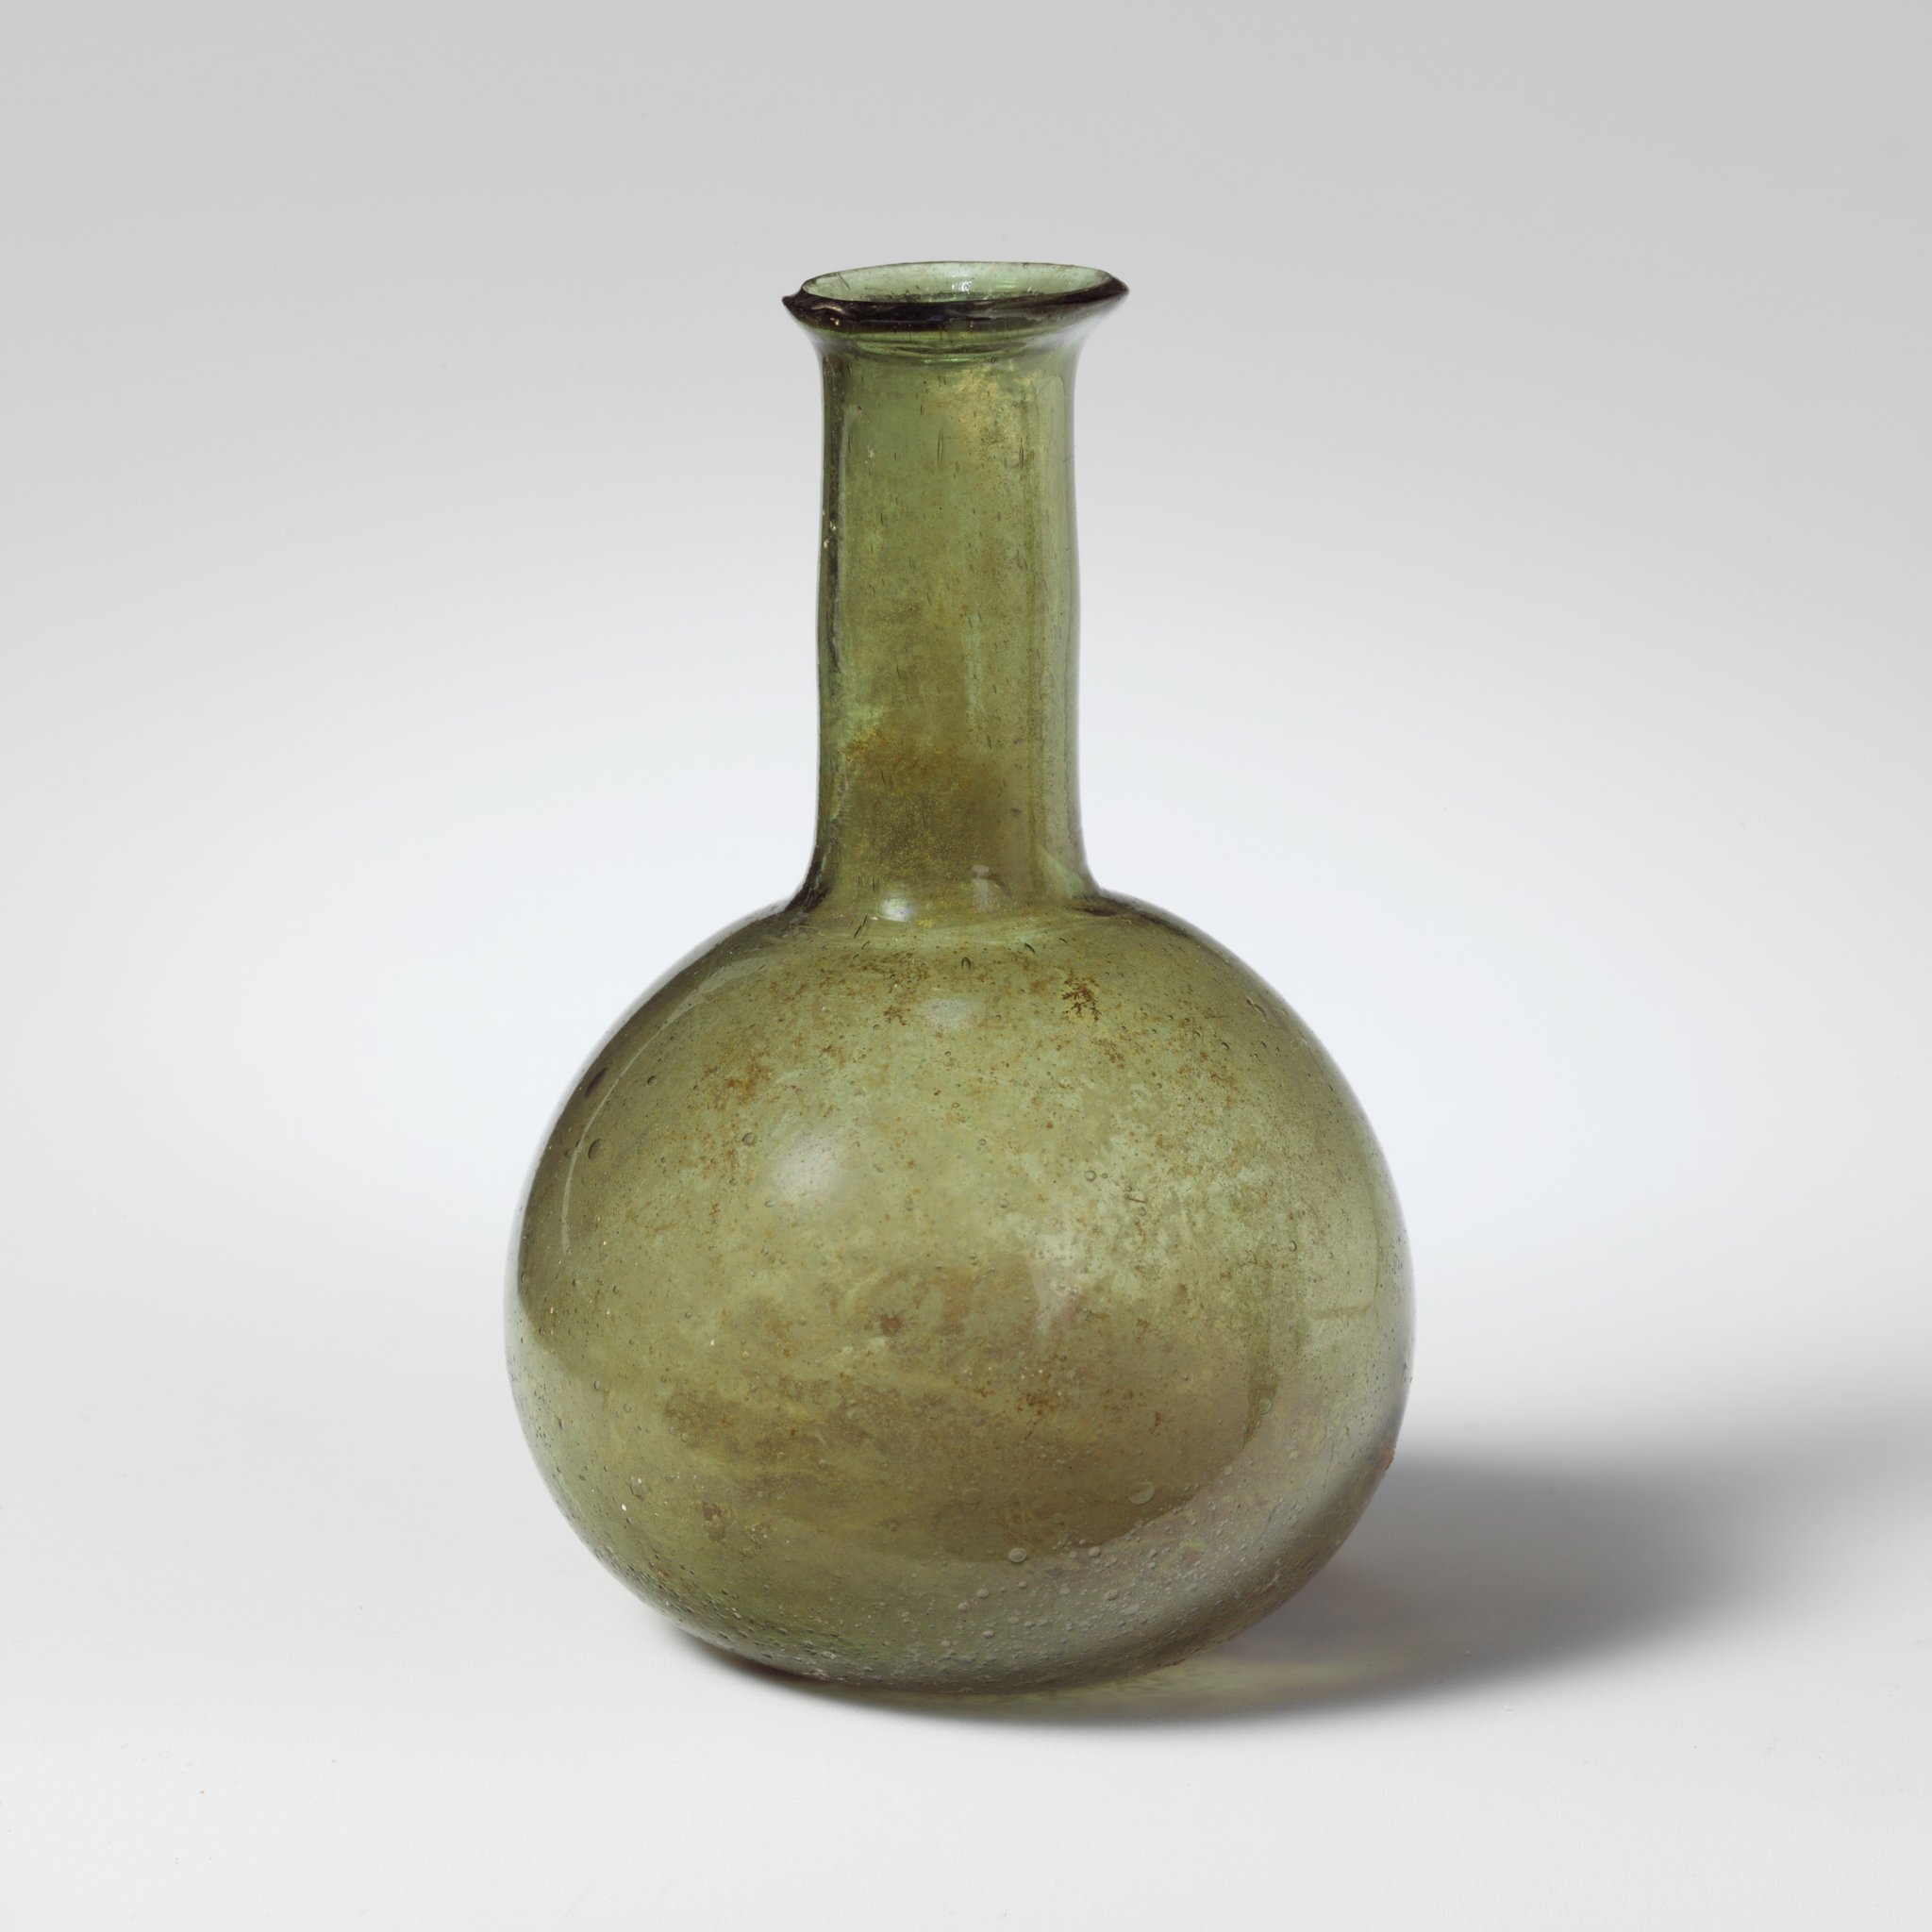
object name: perfume bottle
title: Glass perfume bottle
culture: roman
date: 201-300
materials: glass